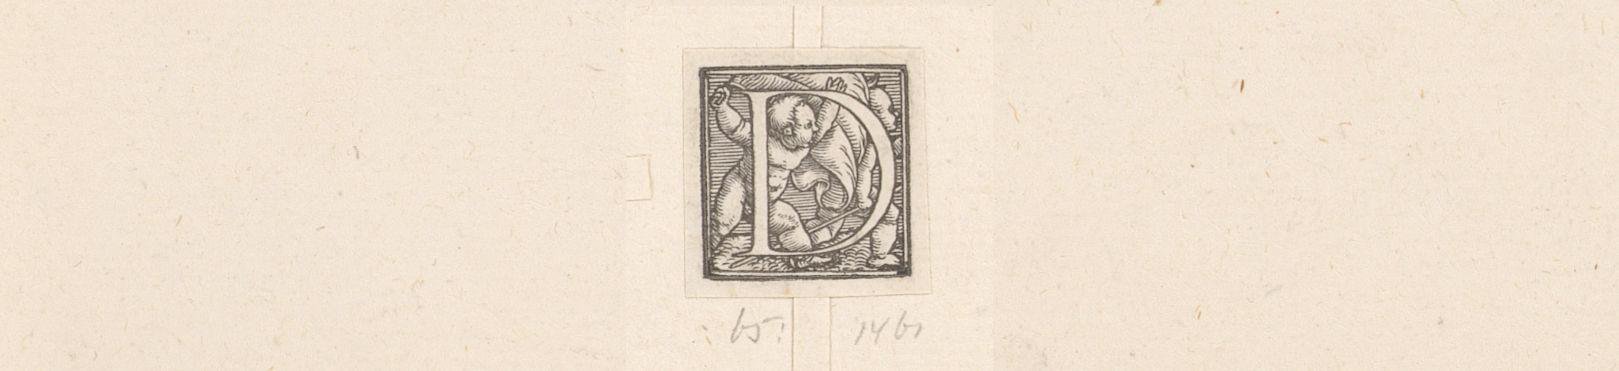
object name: album leaf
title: Initiaal D met twee kinderen waarvan een met banier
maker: hans lützelburger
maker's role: print maker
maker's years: -1526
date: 1522-1526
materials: paper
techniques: woodcut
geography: basel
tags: initial, cupids: 'amores', 'amoretti', 'putti'